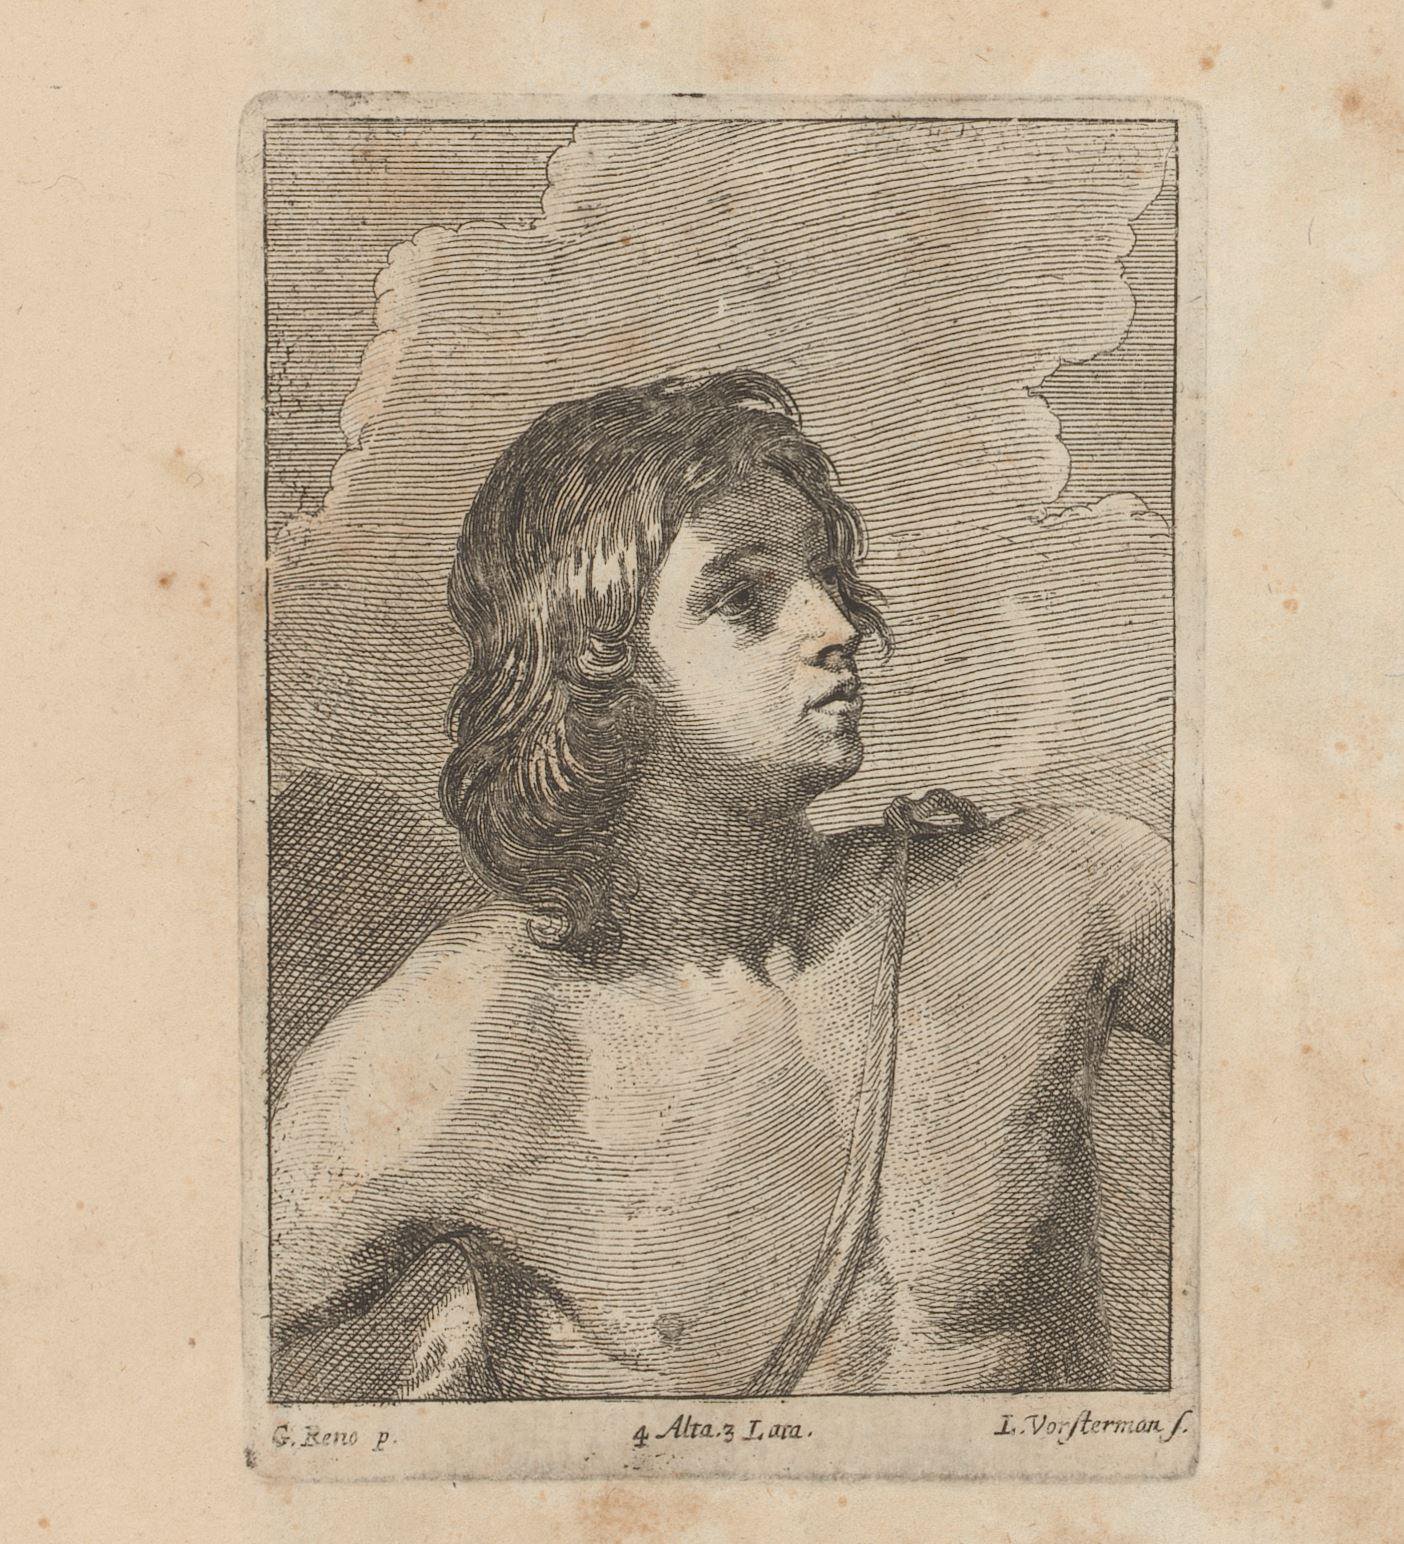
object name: album leaf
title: Jonge David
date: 1660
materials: paper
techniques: etching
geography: brussels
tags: story of david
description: De prent is vervaardigd naar het schilderij van Reni dat zich in de collectie van het Kunsthistorisches Museum te Wenen bevindt (inventarisnummer GG_244). David Teniers heeft waarschijnlijk van alle schilderijen uit de collectie van Leopold Willem van Oostenrijk een olieverfstudie op doek of paneel vervaardigd (zgn. pasticcio), die als voorbeeld voor de prentmakers diende. Het is niet altijd duidelijk of de pasticci door hem zijn gemaakt of door zijn atelier. Niet alle pasticci zijn overgeleverd.